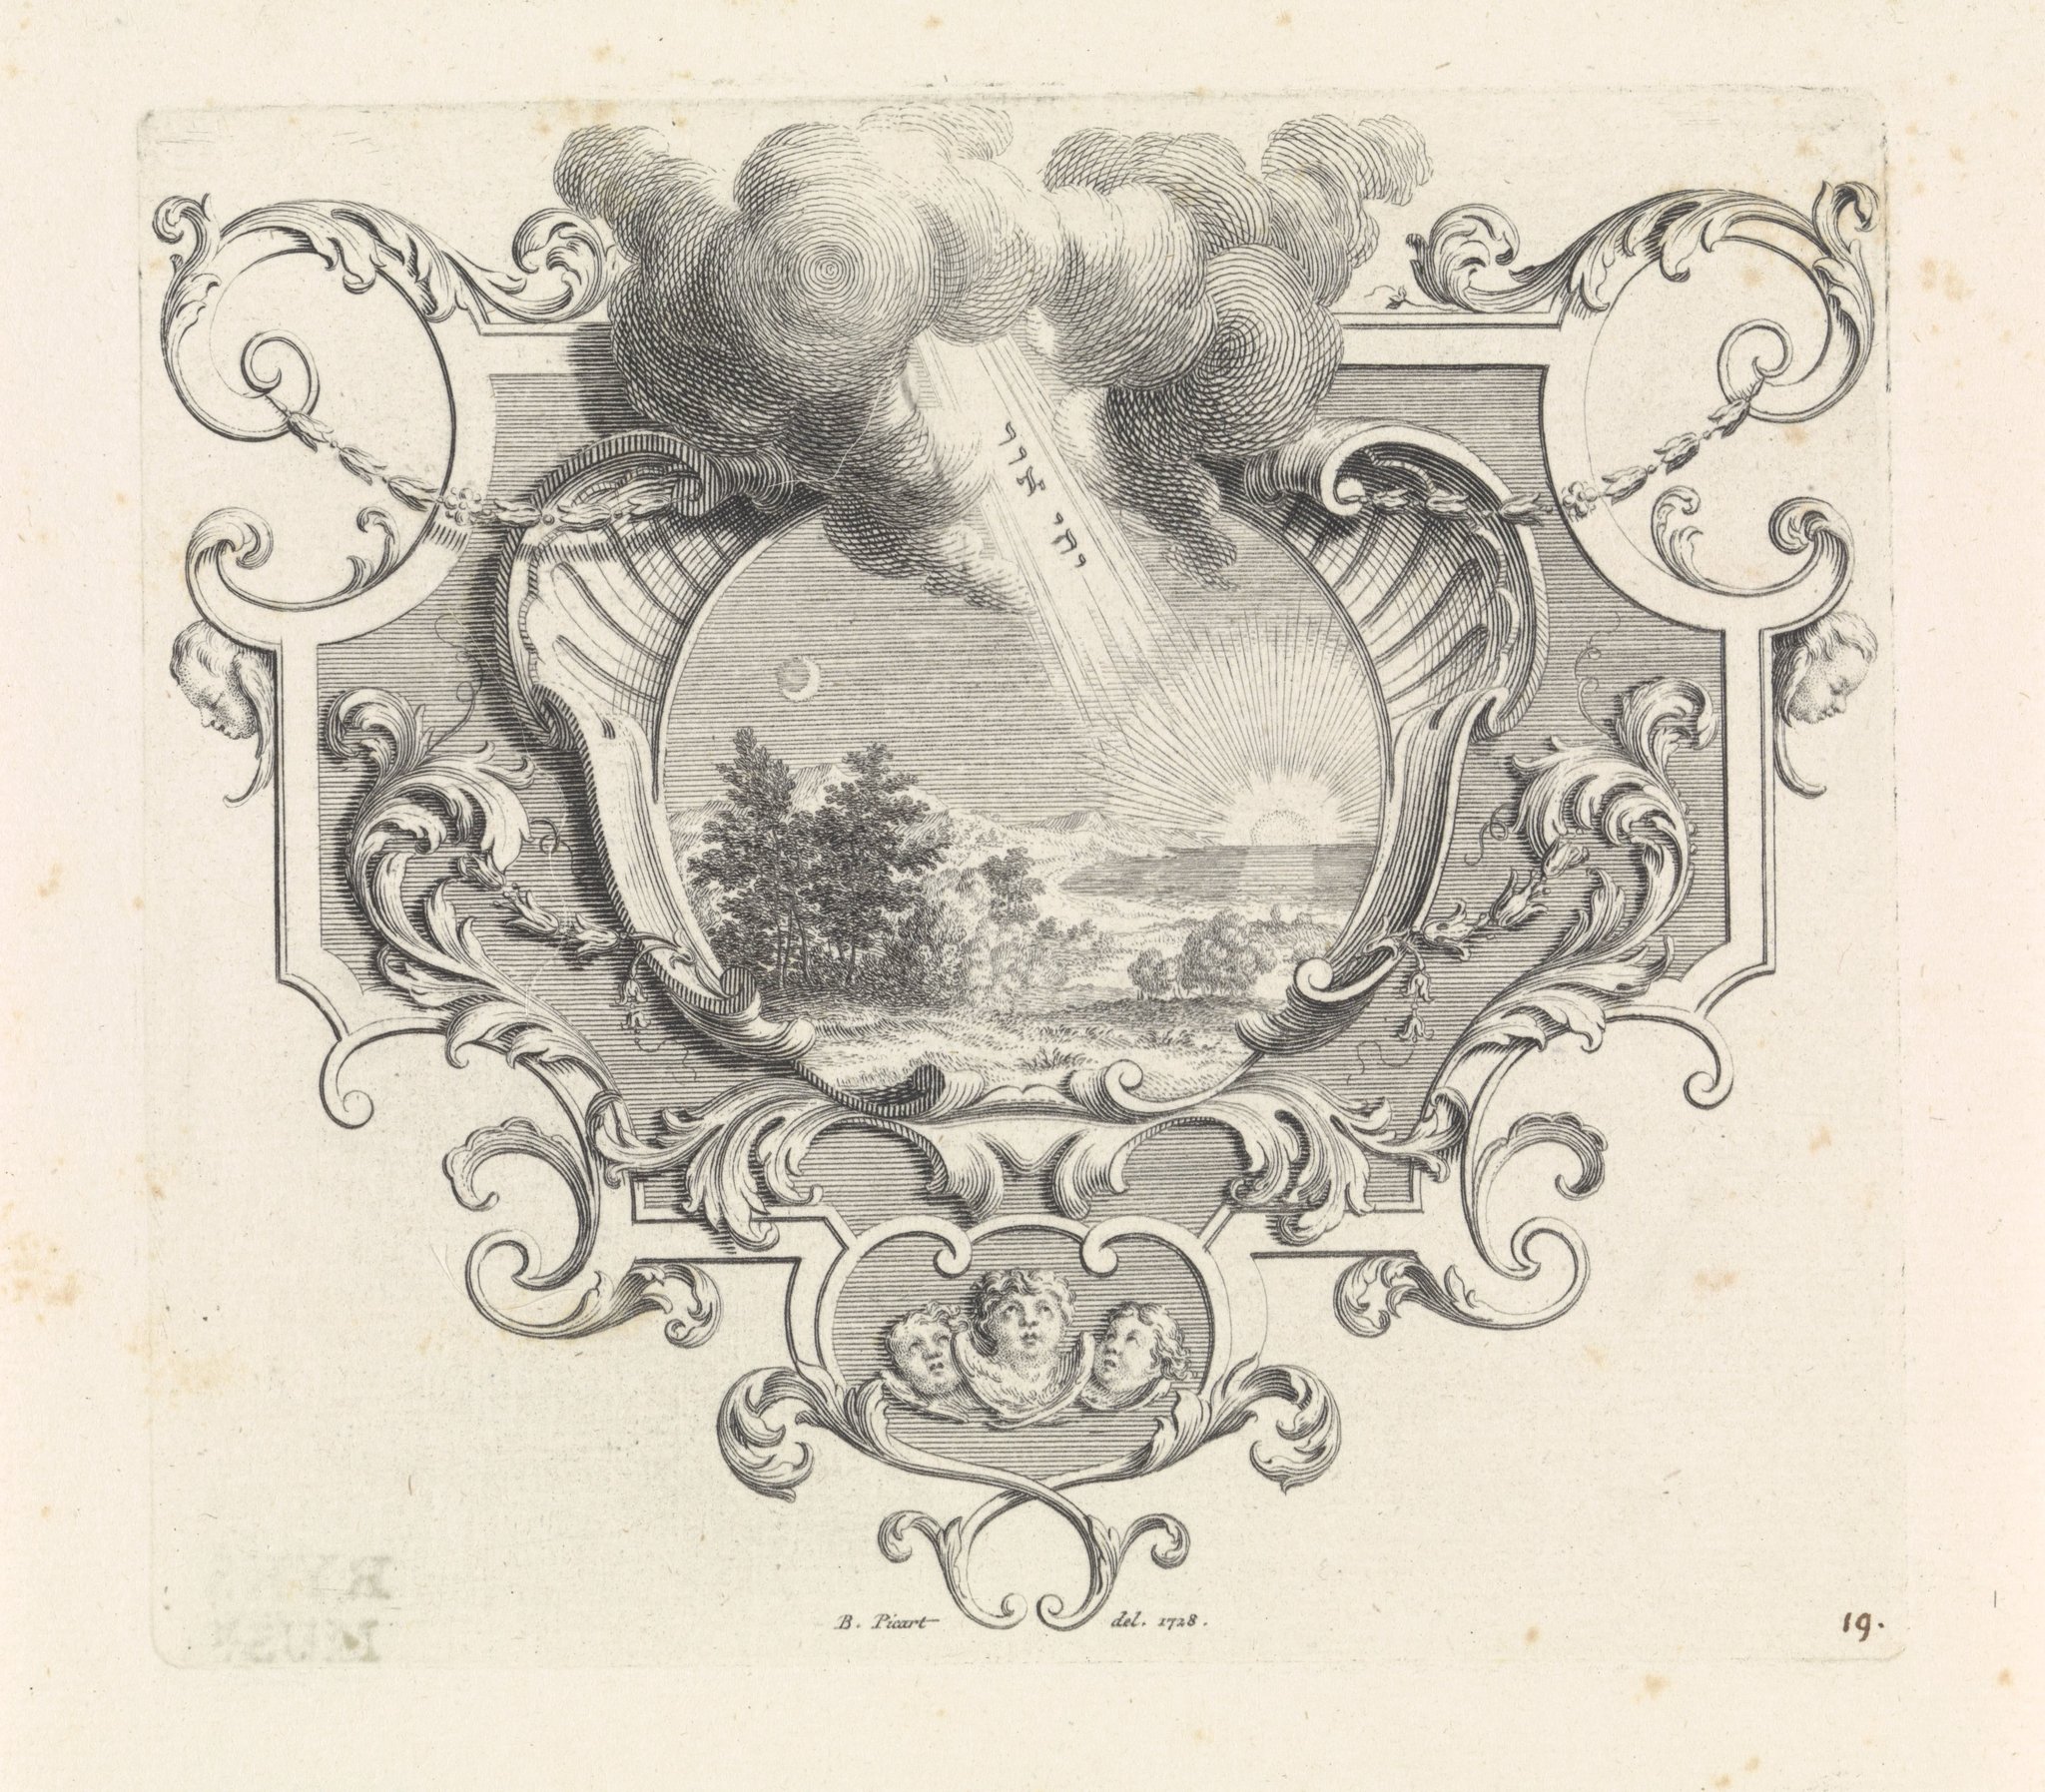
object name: ornament print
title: Tetragram en zon en maan in ornamentele omlijsting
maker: bernard picart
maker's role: draughtsman, print maker, publisher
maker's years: 1673-1733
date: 1728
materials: paper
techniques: engraving, etching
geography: amsterdam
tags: ornaments ~ art, (symbolic) representations ~ creation, cosmos, cosmogony, universe, and life (in the broadest sense), tetragram (in roman or hebrew script) ~ symbol of god the father, tetragram (in hebrew script) ~ jewish religion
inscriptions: number: ‘19.’, collector's mark: Lugt 2165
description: Prent mogelijk gebruikt in: Boileau-Despréaux, Nicolas. Oeuvres. Amsterdam: François Changuion, Den Haag, Pieter de Hondt, 1729. Nummer 19 in: Explication des Vignettes de la Seconde Edition des Oeuvres de Boileau. Amsterdam: Bernard Picart, 1729.